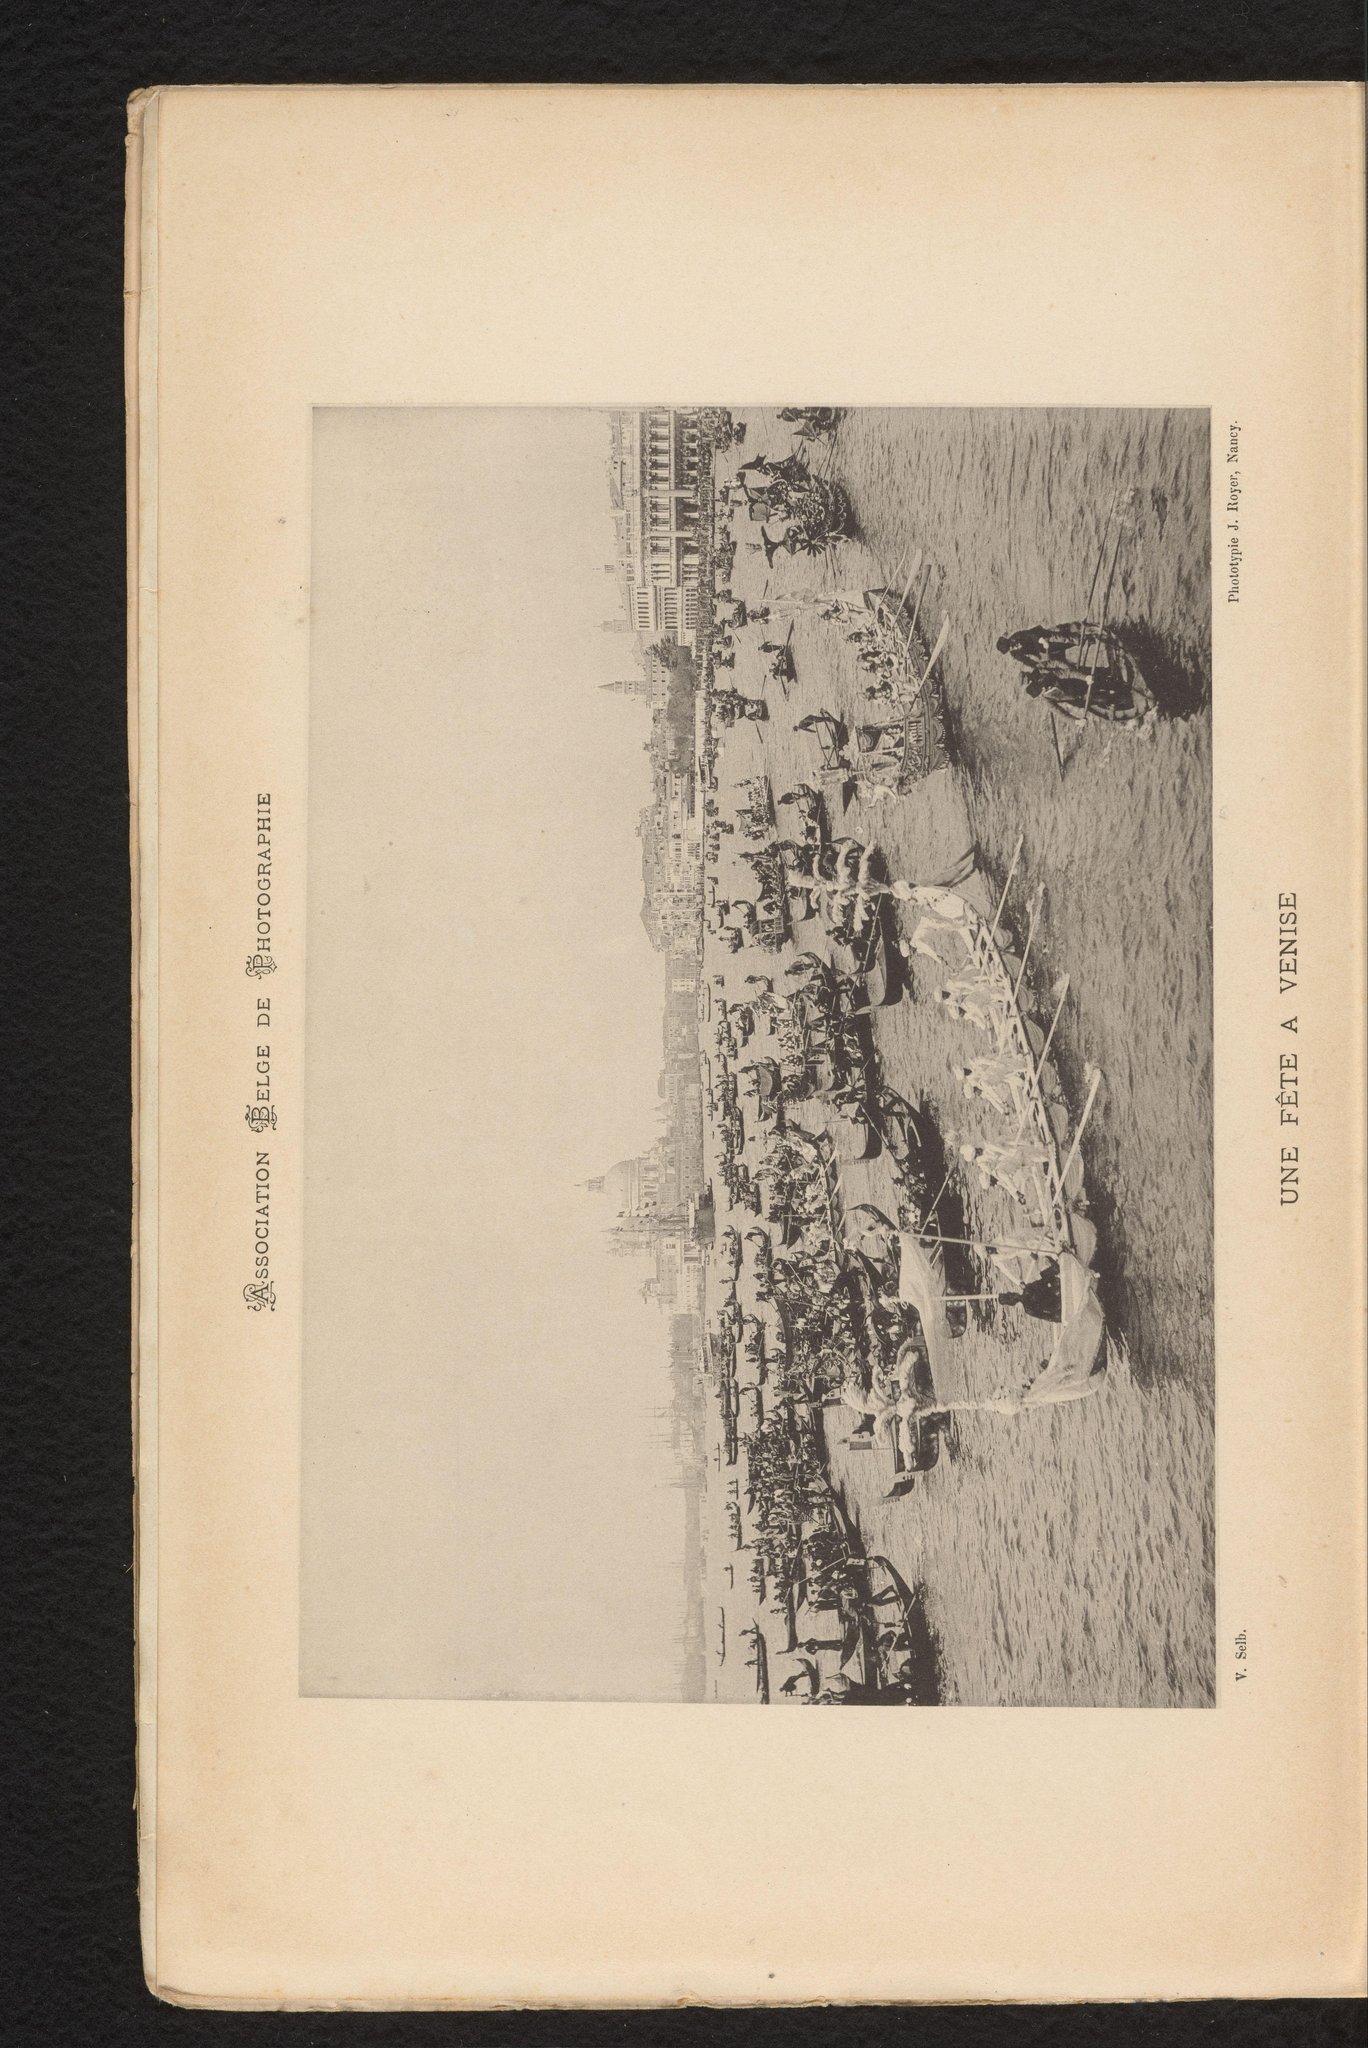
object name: page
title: Gezicht op roeiboten in de haven van Venetië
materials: paper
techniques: photograph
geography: nancy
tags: rowing-boat, canoe, etc., venice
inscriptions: inscription: ‘Association Belge de Photographie’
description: Prent op tweede ongenummerde pagina na pagina XVI.